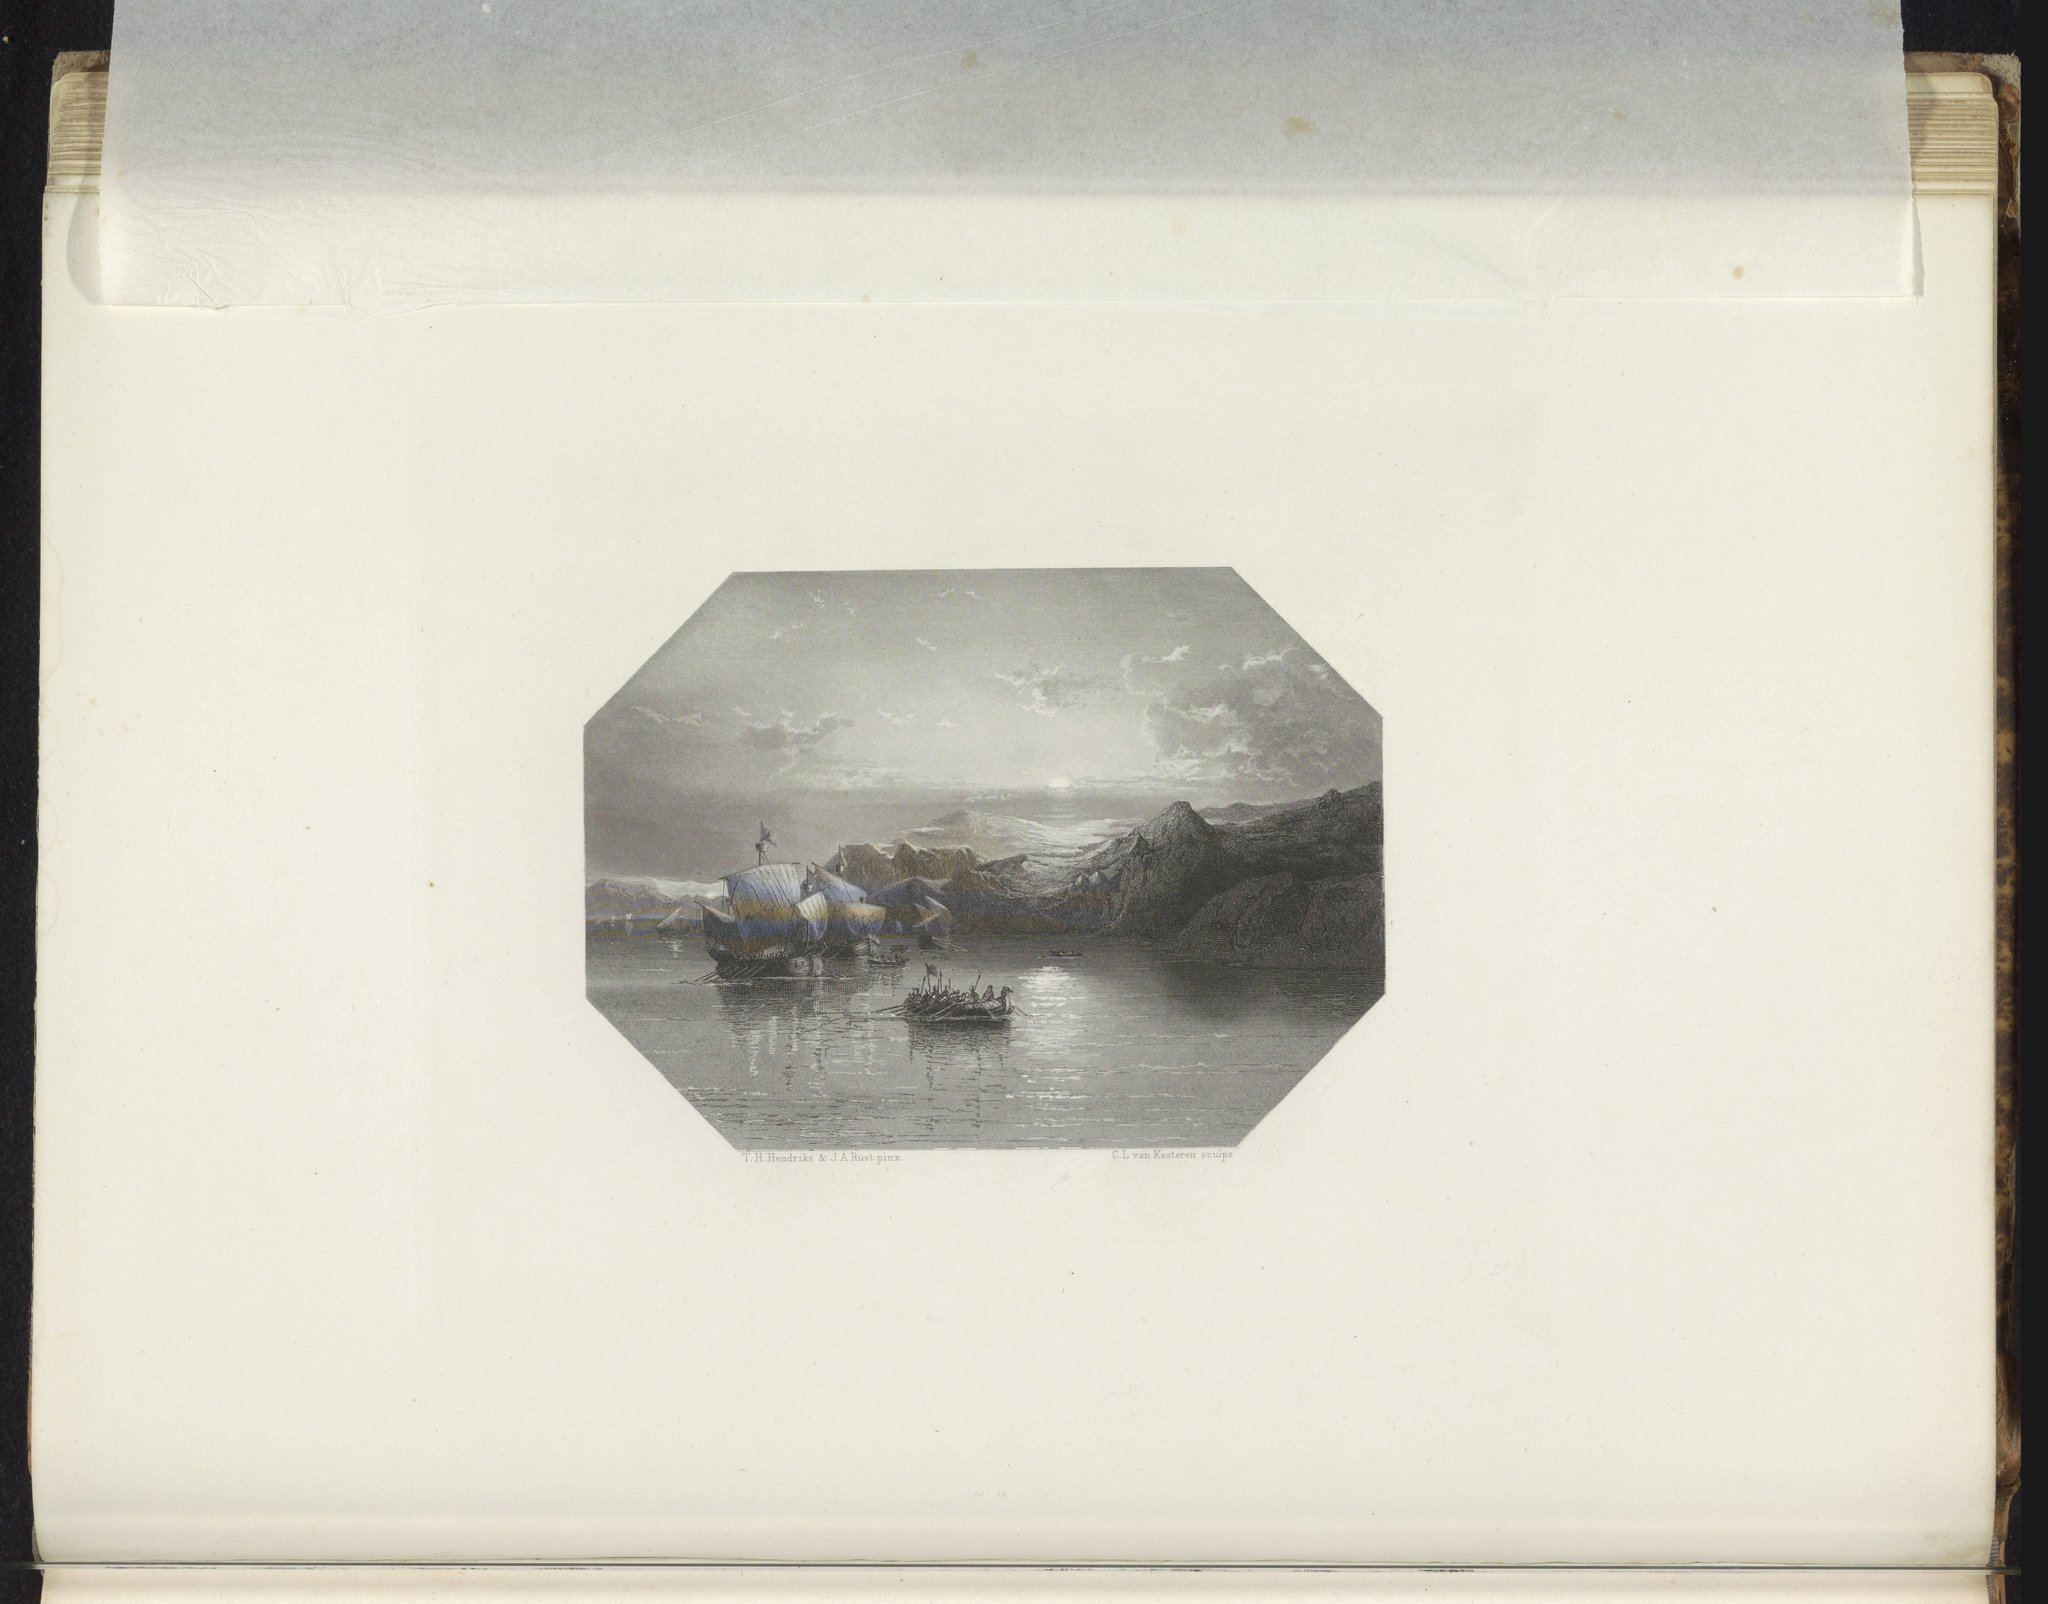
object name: history print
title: Friese schepen op ontdekkingsreis, ca. 1038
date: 1865-1870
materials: paper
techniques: engraving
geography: netherlands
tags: exploration, expedition, voyage of discovery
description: Friese schepen op ontdekkingsreis in het Noorden, ca. 1038. Schepen en sloep in een baai tussen bergen. Onderdeel van de groep staalgravures naar de schilderijen van de Historische Galerij der Maatschappij Arti et Amicitiae.